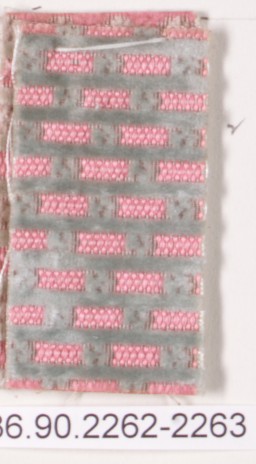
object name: piece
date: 1801-1900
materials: silk